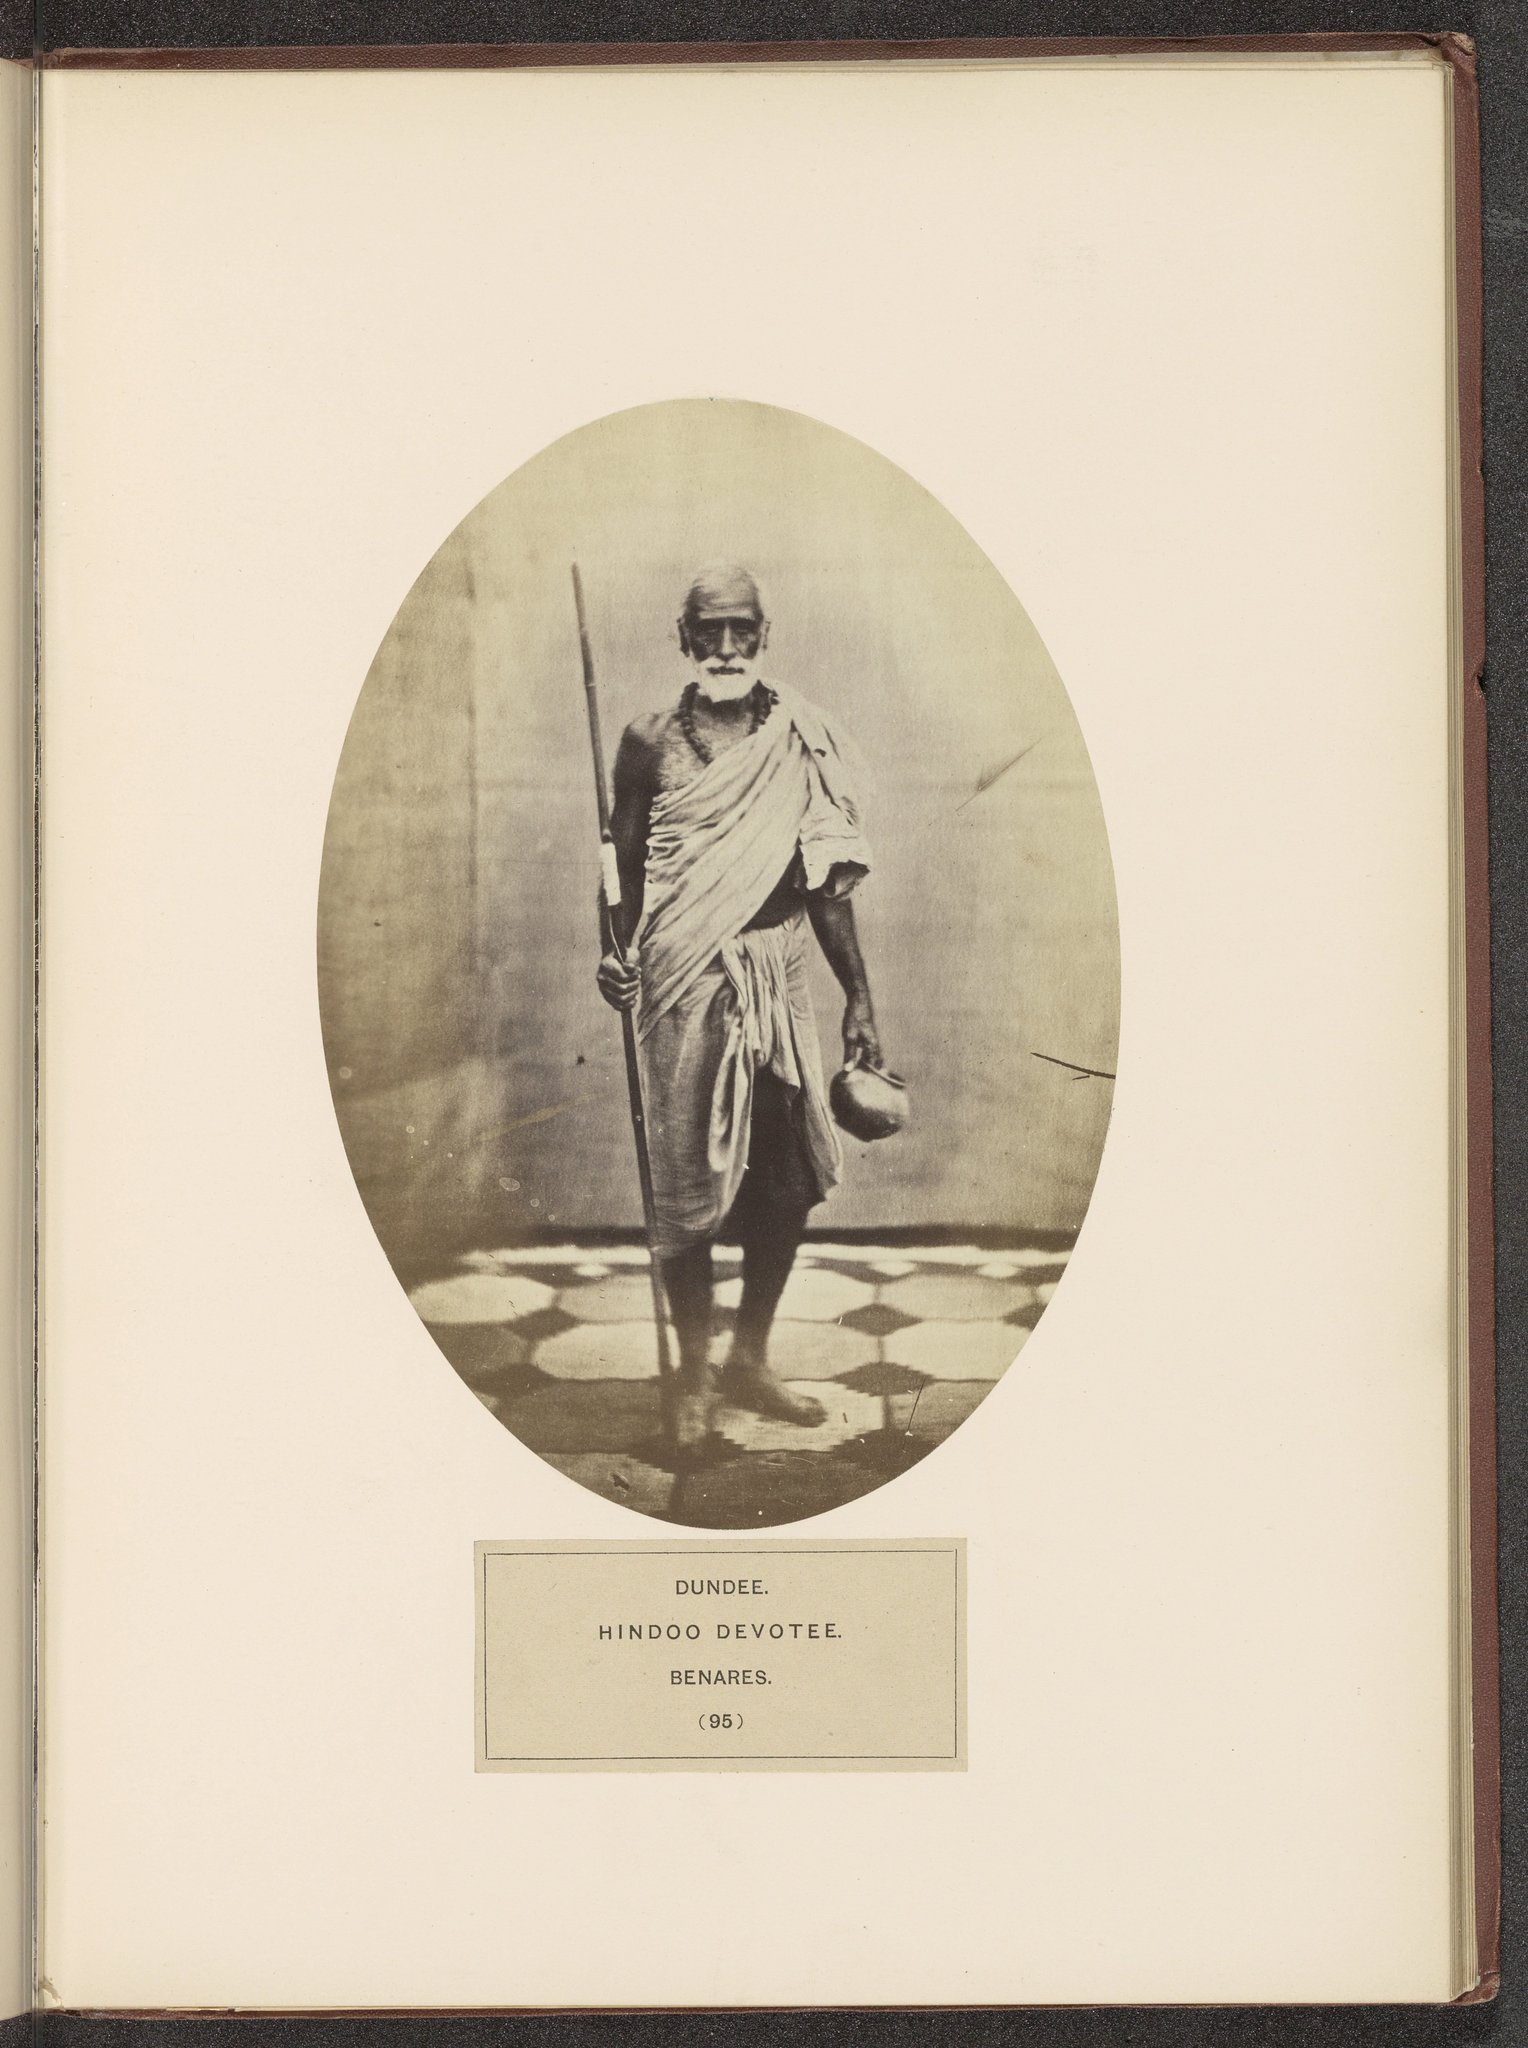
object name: page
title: Portrait of an unknown man from the Dundi sect of Varanasi, Uttar Pradesh, India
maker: Anonymous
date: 1858-1868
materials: photographic support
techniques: albumen print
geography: varanasi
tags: hinduism, buddhism, jainism, human races; peoples; nationalities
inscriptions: inscription: ‘DUNDEE./ HINDOO DEVOTEE./ BENARES.’, number: ‘(95)’